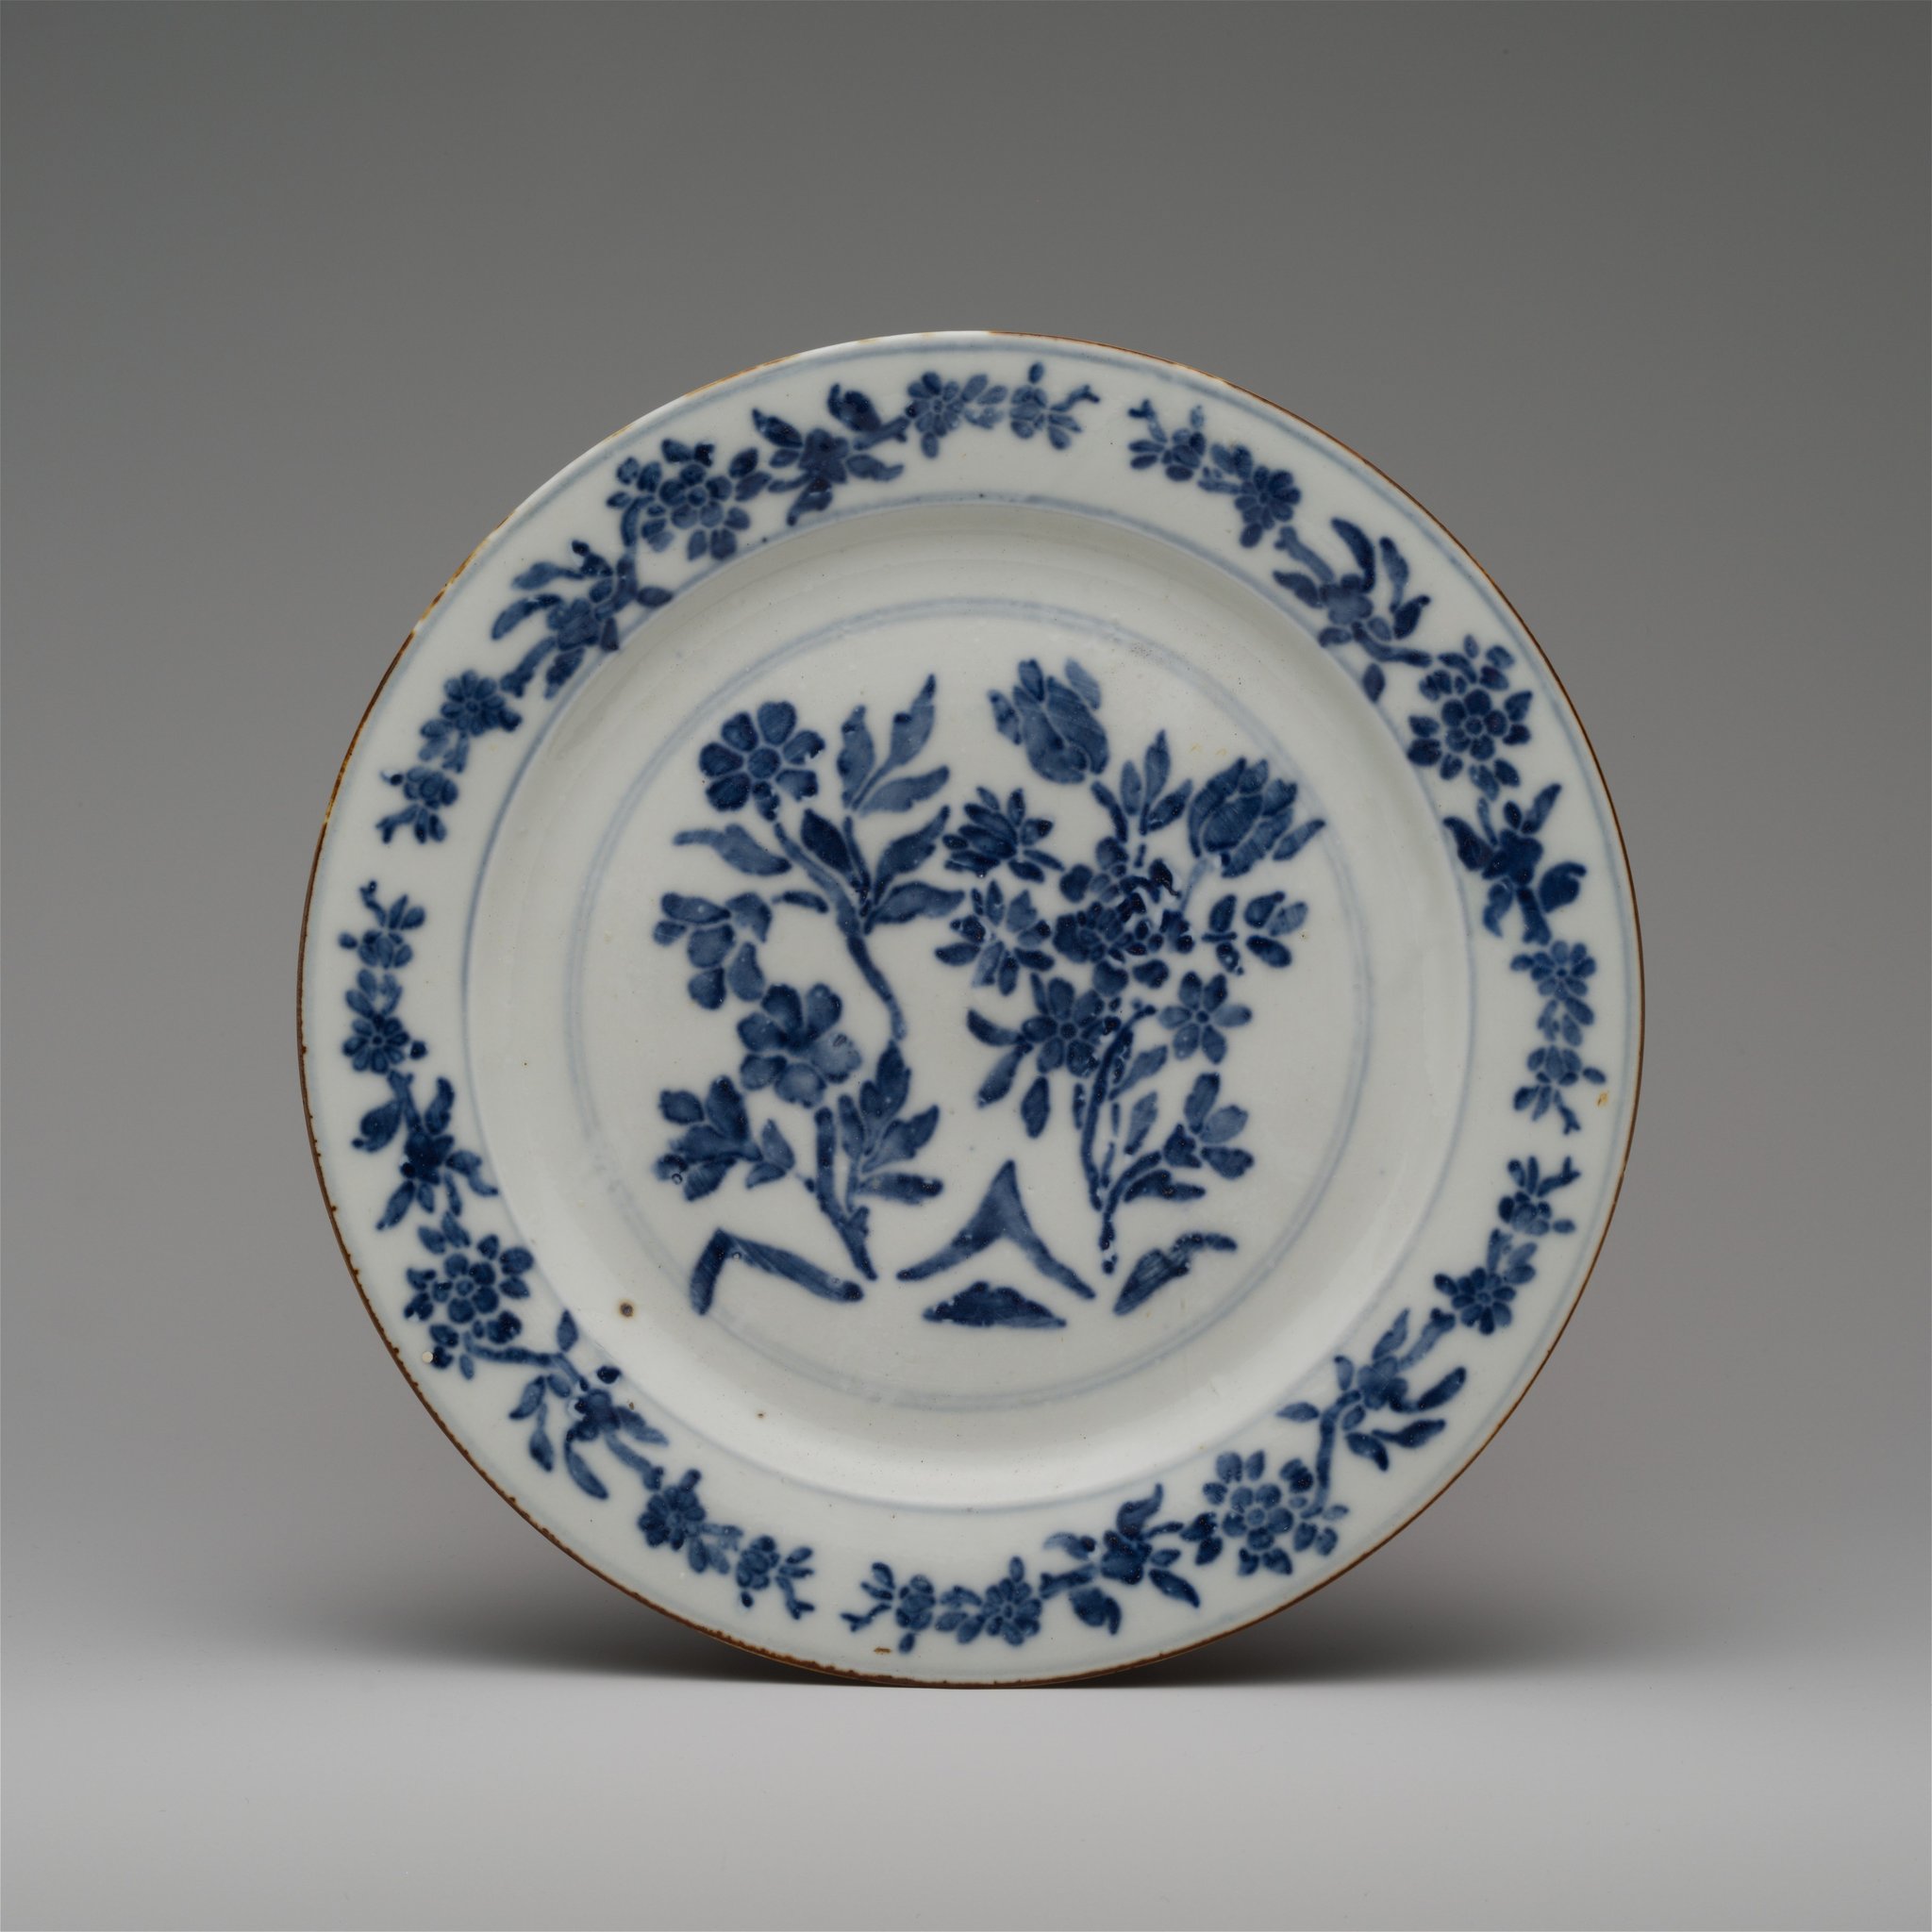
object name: plate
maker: doccia porcelain manufactory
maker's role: manufactory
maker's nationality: italian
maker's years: 1737-1896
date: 1745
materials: hard paste porcelain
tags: flowers